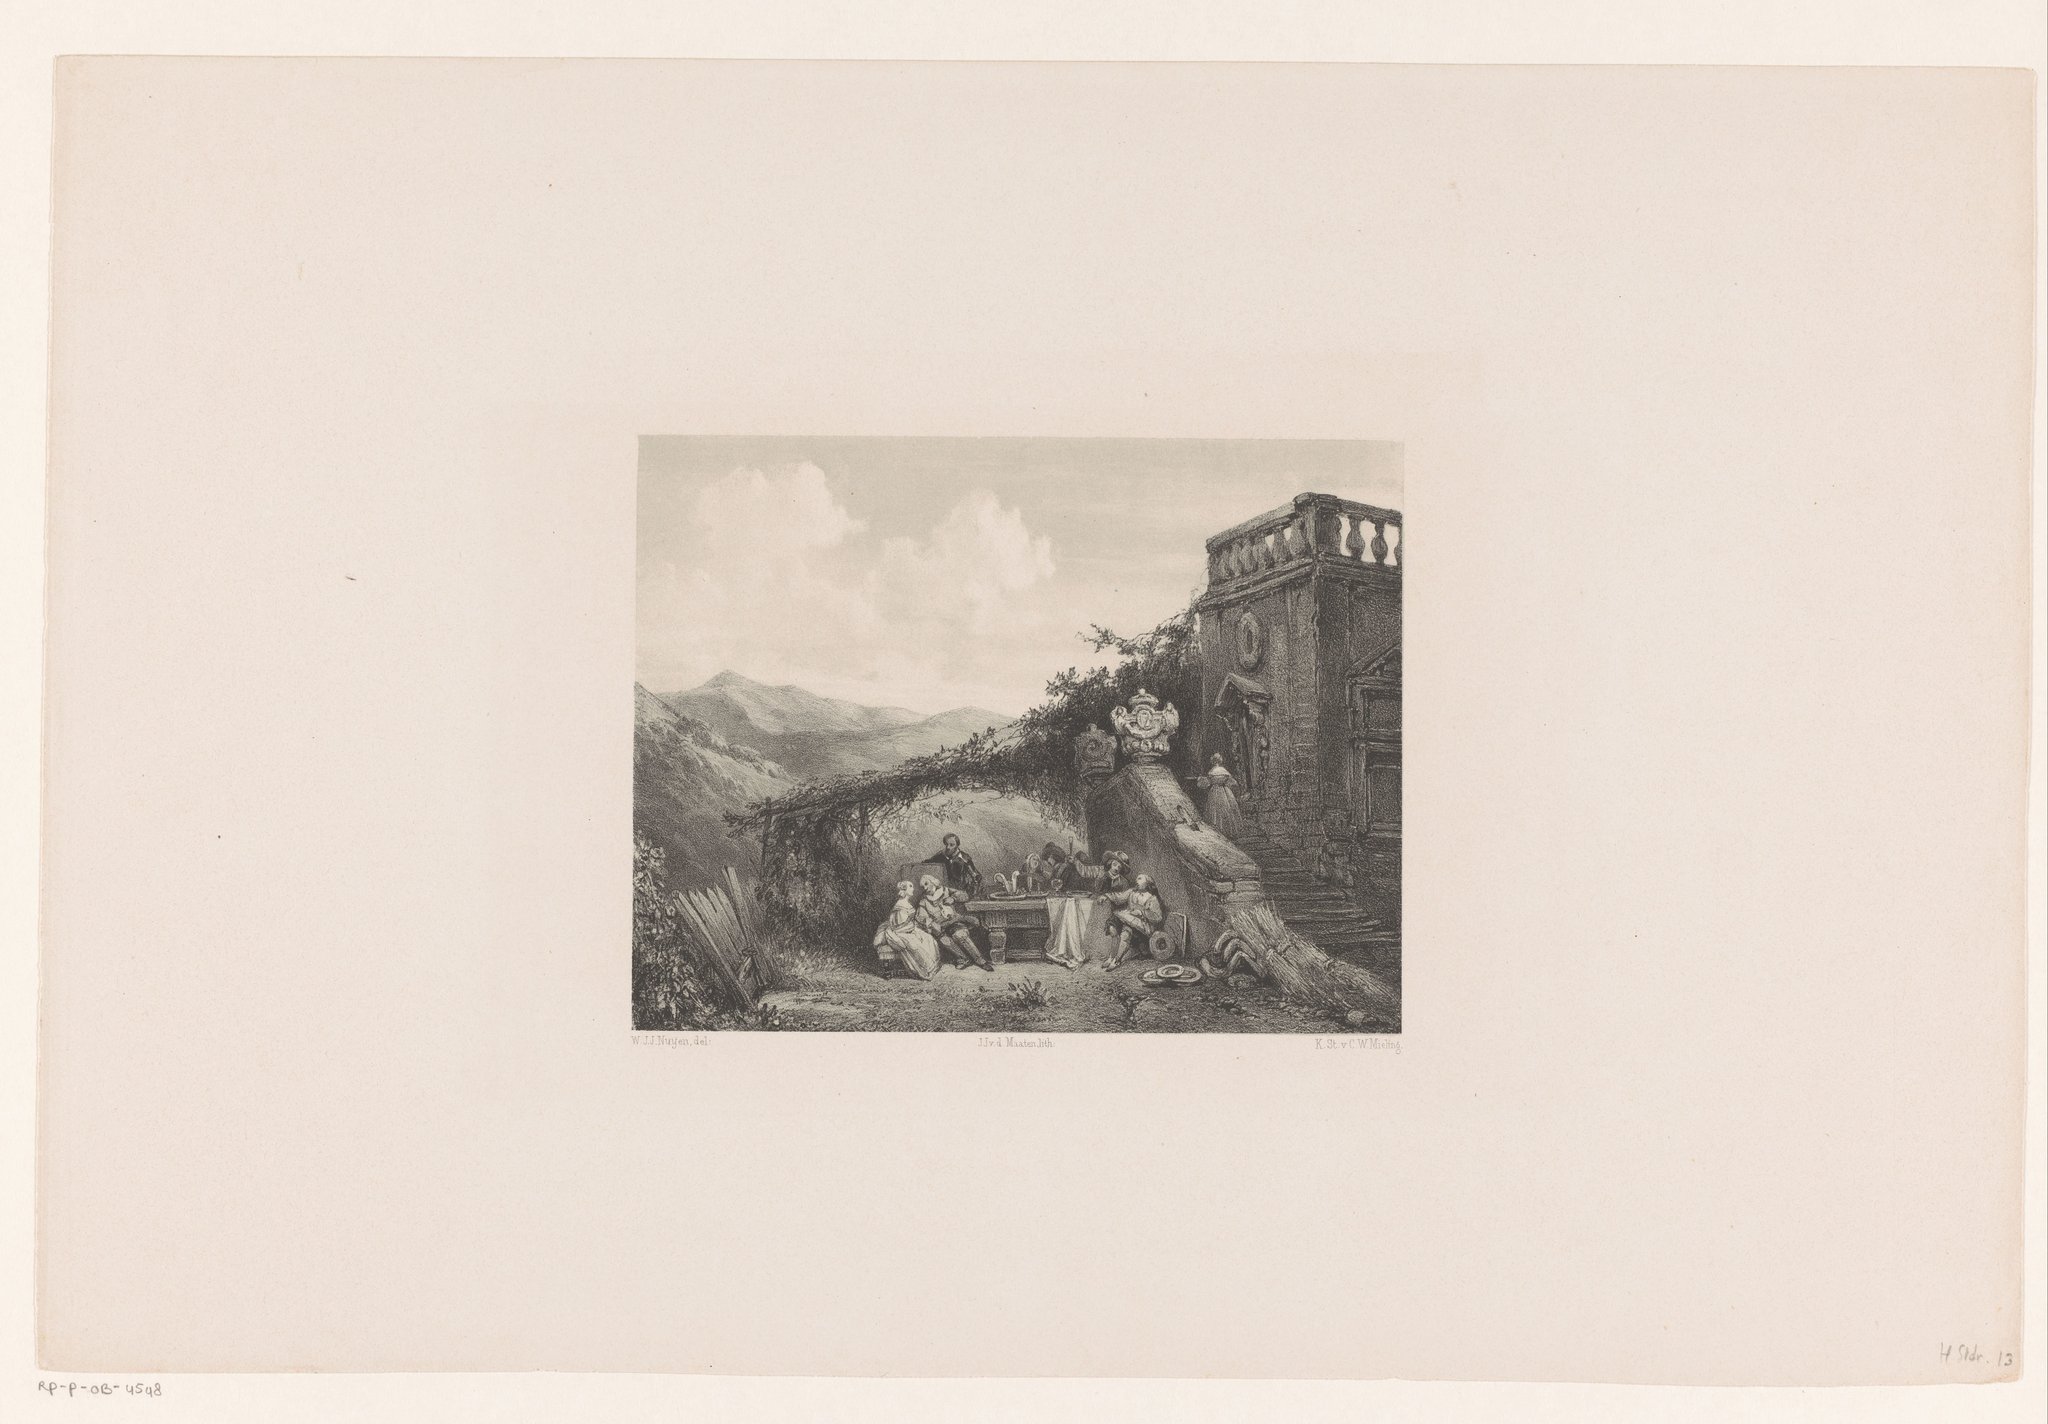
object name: print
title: Dinerend gezelschap in de buitenlucht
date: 1830-1865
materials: paper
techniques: tone lithography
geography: the hague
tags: evening meal, dinner, supper - cc - out of doors, rural housing, e.g. country-house, villa, cottage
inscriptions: collector's mark: Lugt 2228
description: Het gezelschap zit buiten onder een afdak bij een villa. Een bediende loopt de trap op naar de ingang.